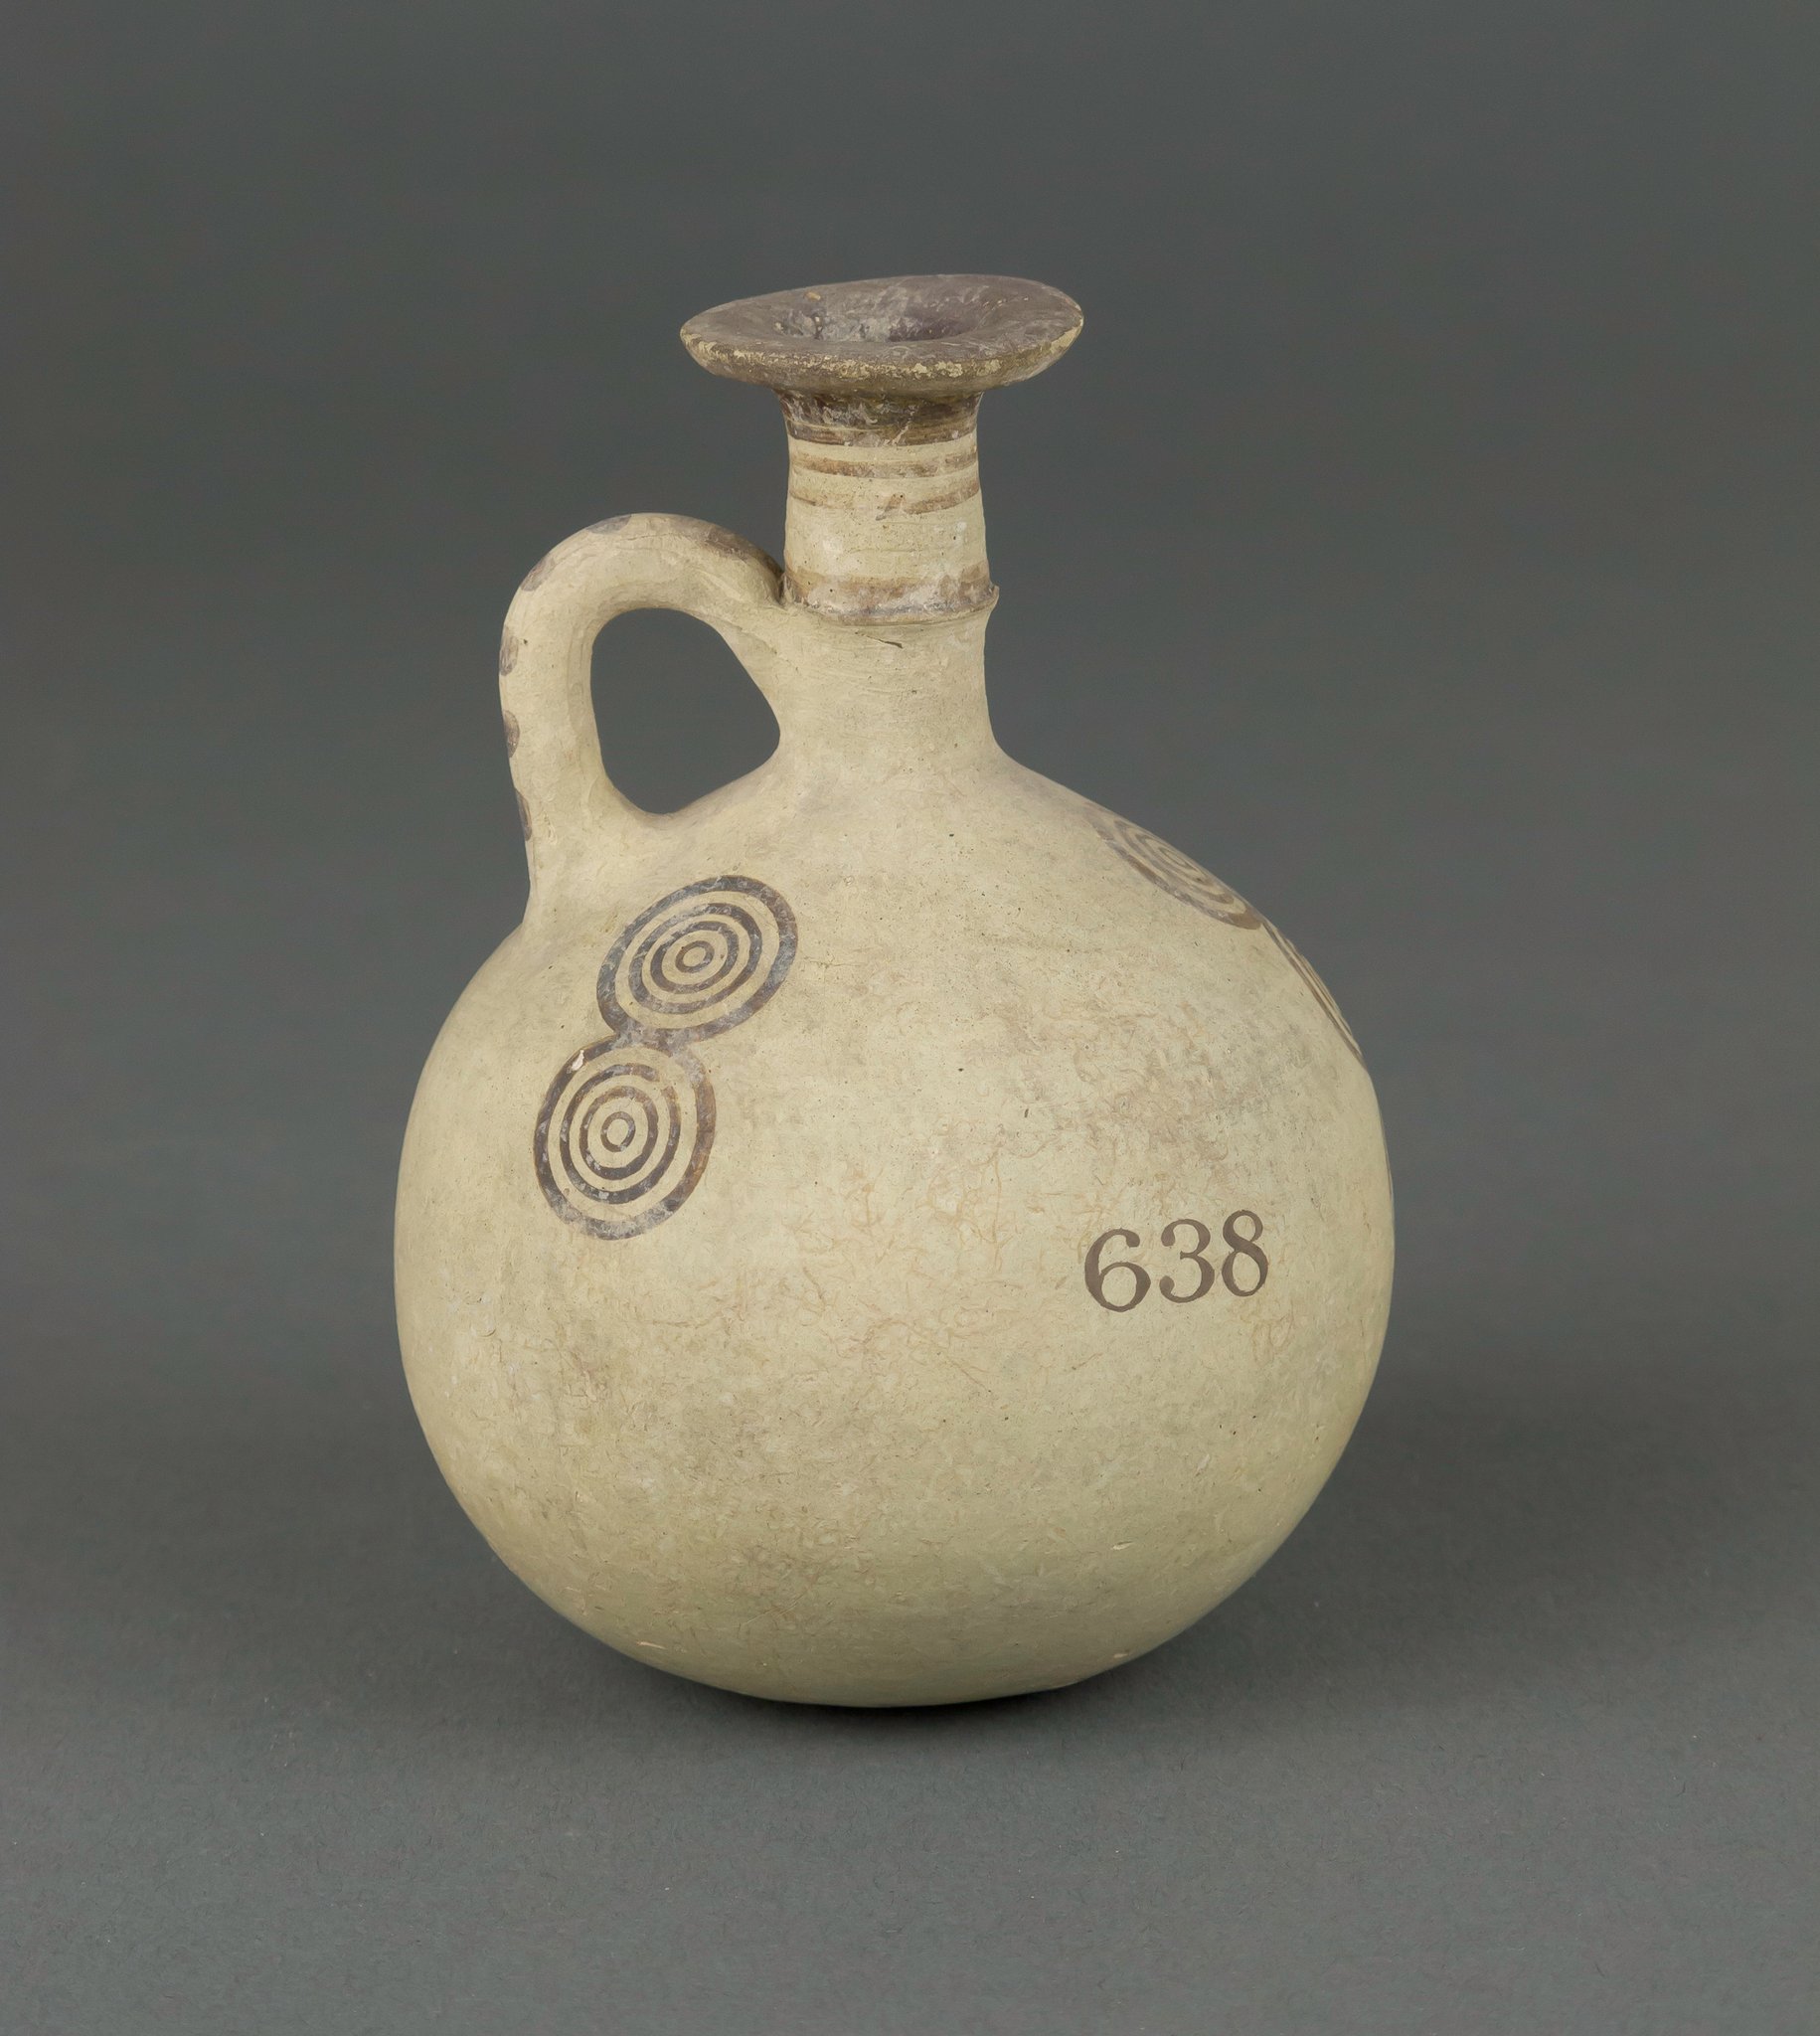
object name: jug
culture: cypriot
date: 1050-900 BCE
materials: terracotta